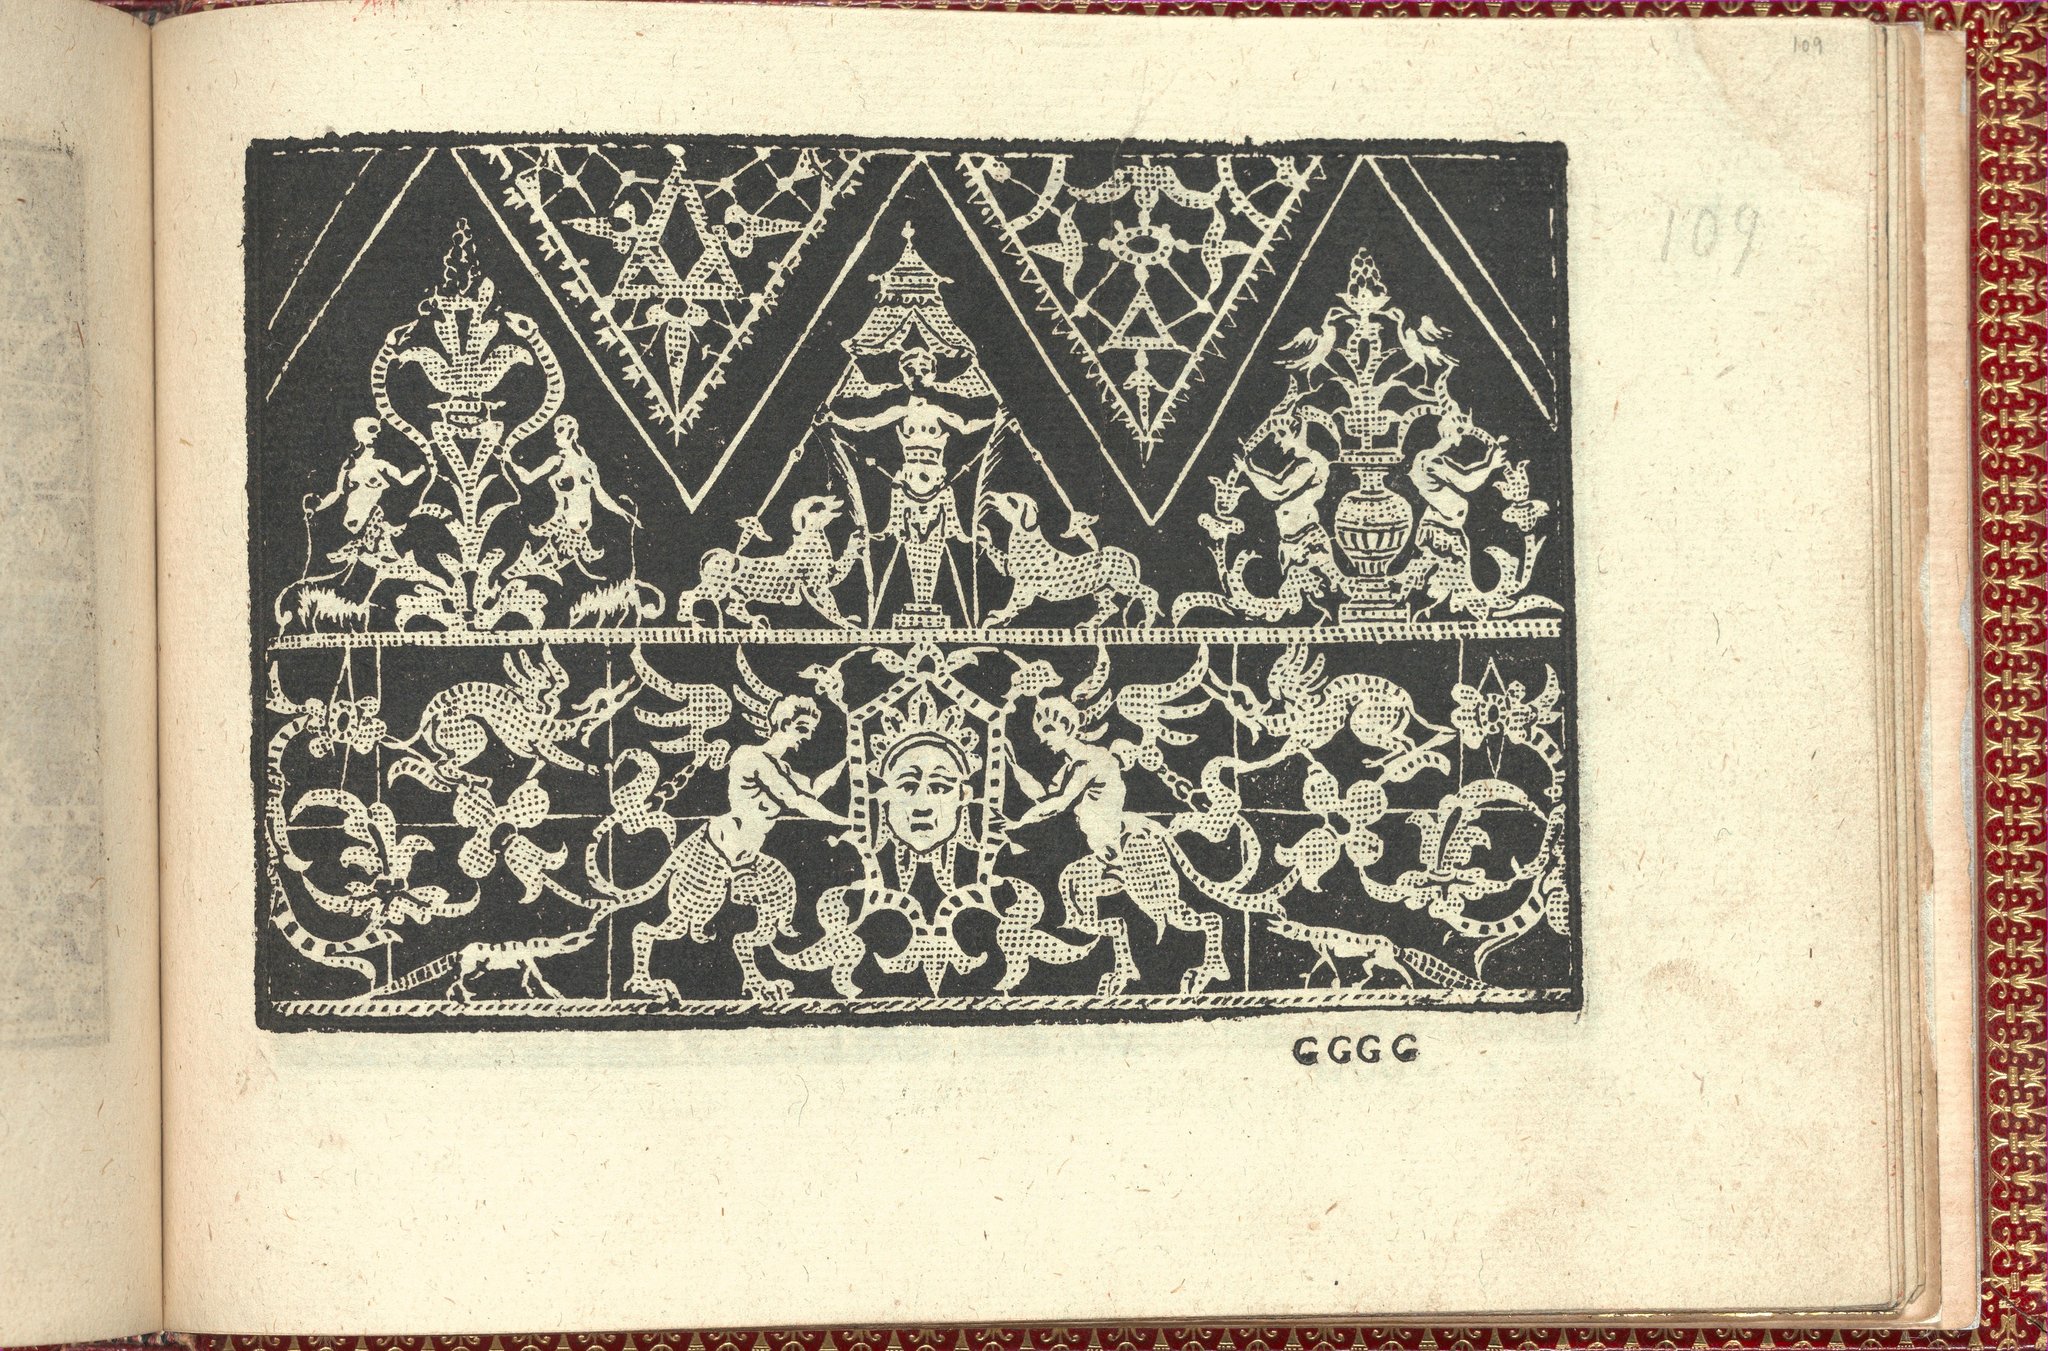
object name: book print ornament architecture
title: Corona delle Nobili et Virtuose Donne: Libro I-IV, page 109 (recto)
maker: cesare vecellio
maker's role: publisher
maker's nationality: italian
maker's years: 1521-1601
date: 1601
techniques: woodcut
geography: italy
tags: men,female nudes,dragons,coat of arms